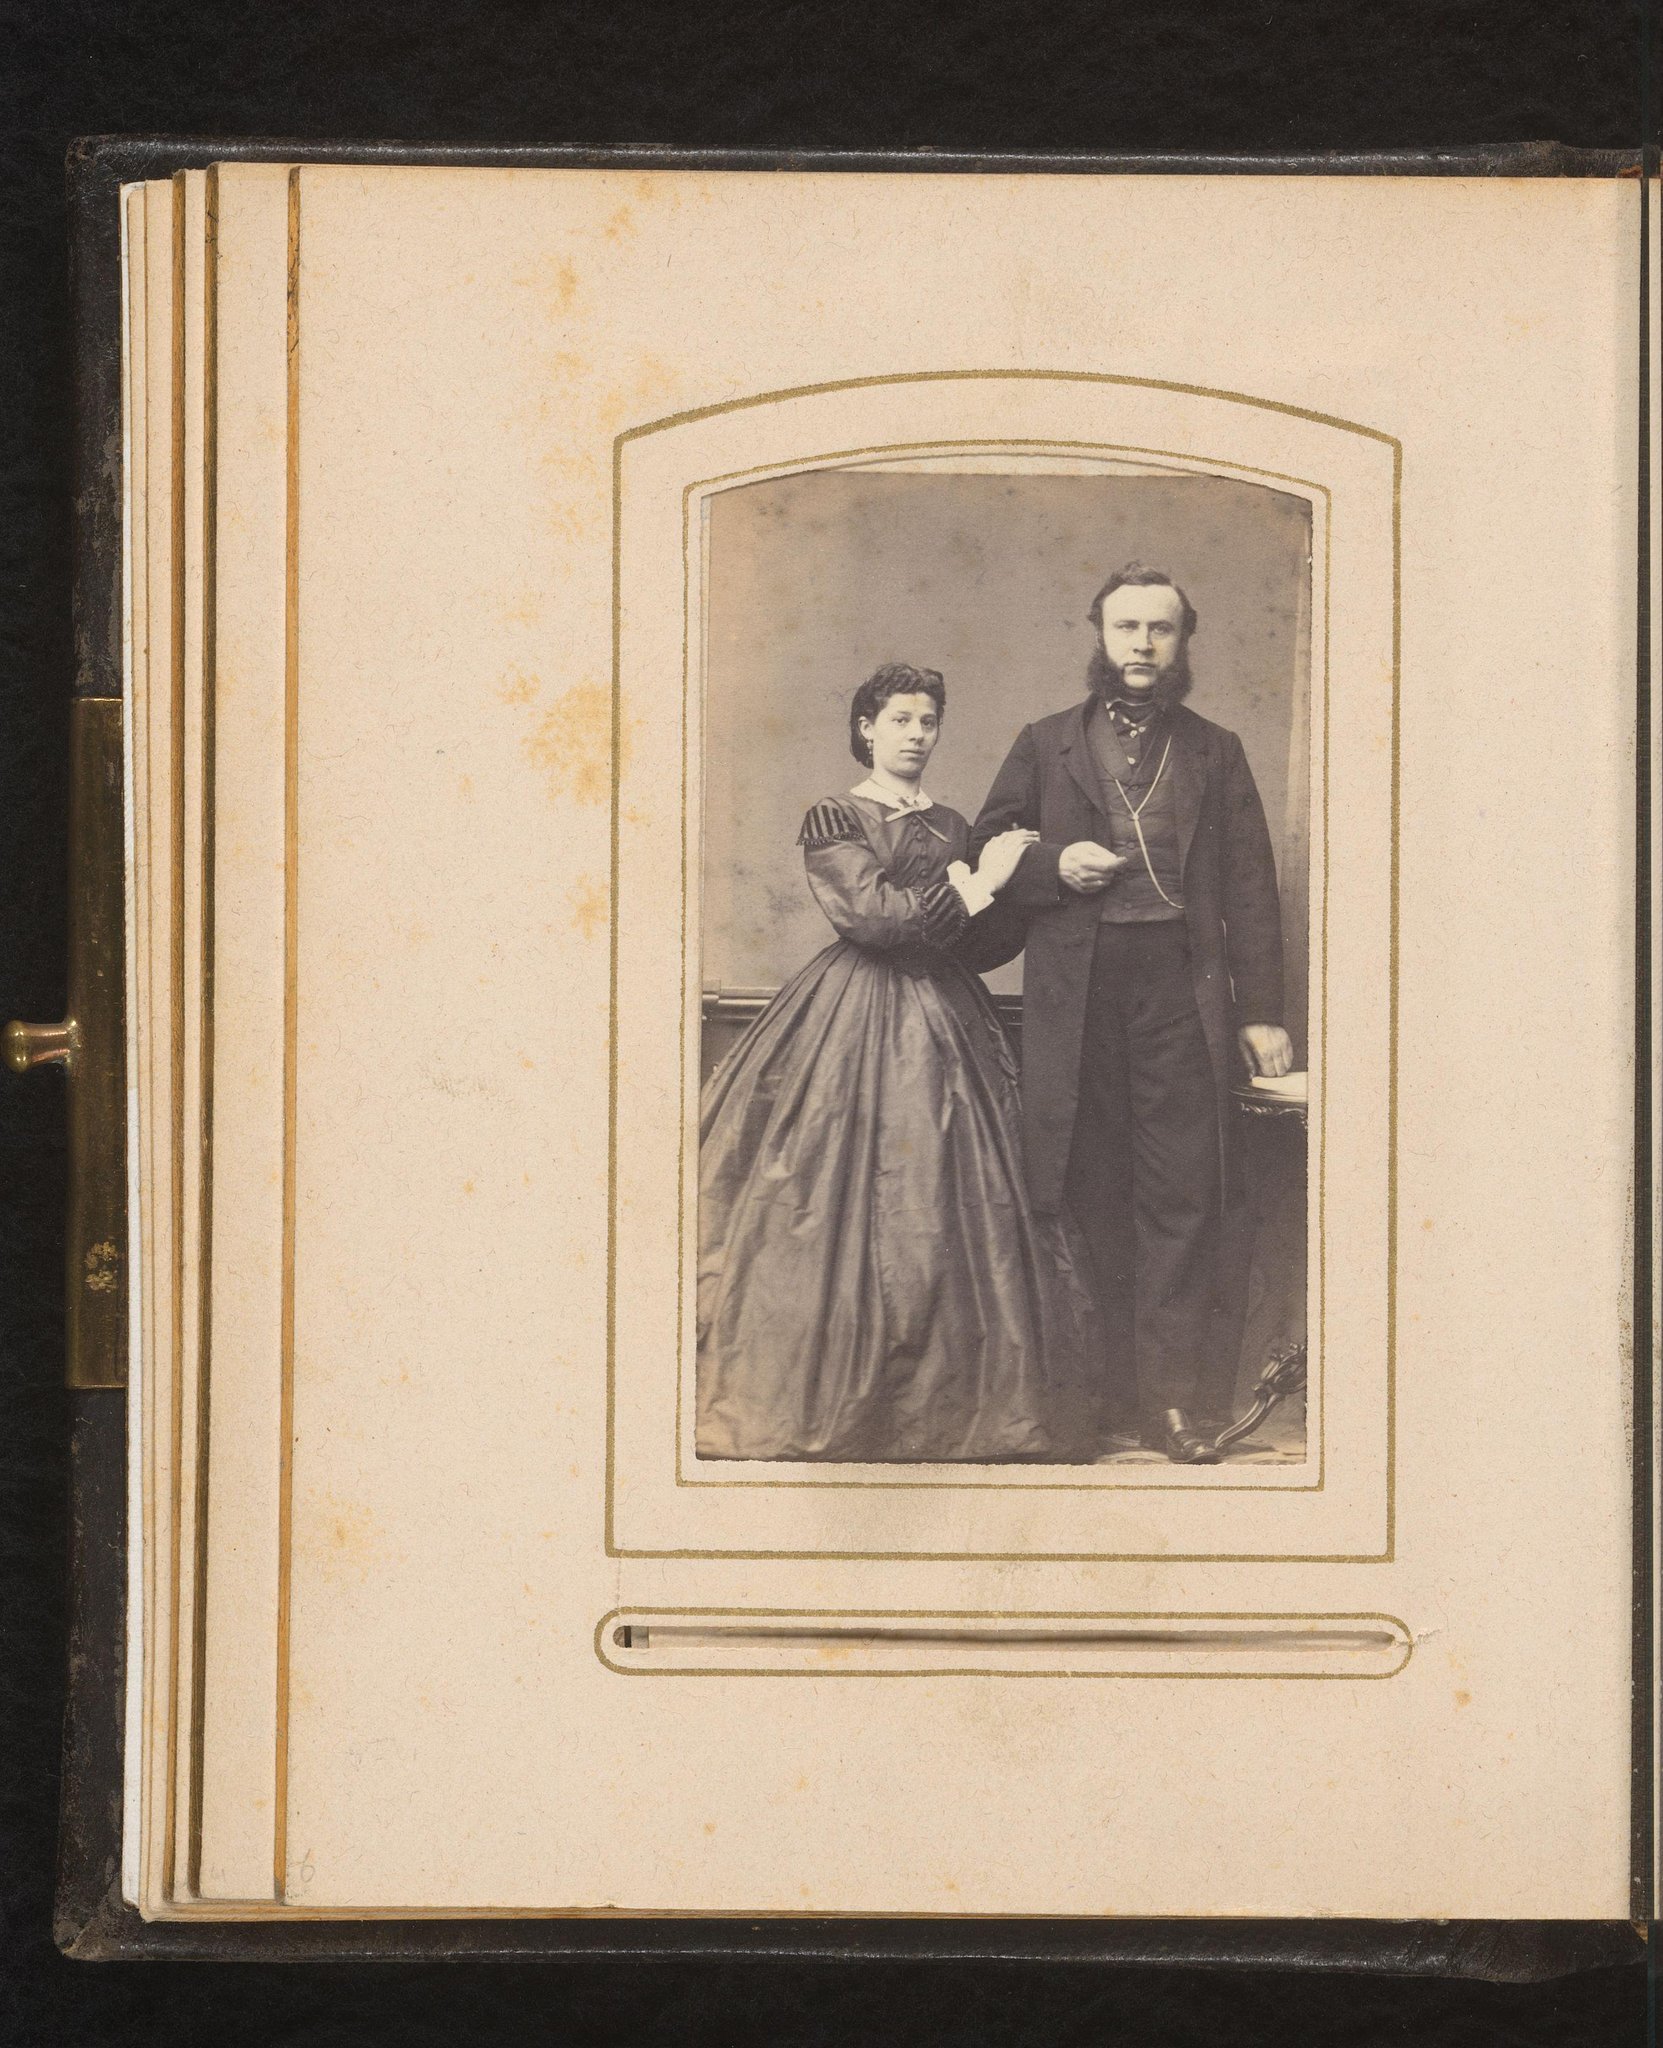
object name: album leaf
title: Portret van een man en vrouw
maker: th. schütz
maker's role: fotograaf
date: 1860-1900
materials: cardboard, photographic support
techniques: albumen print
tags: adult woman, adult man, historical persons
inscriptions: inscription: ‘Photographie/ von/ Th. Schütz/ Georgsstrasse Nr. 55/ Bremen’, annotation: ‘Heinr. Beg[...]/ [...] frau’